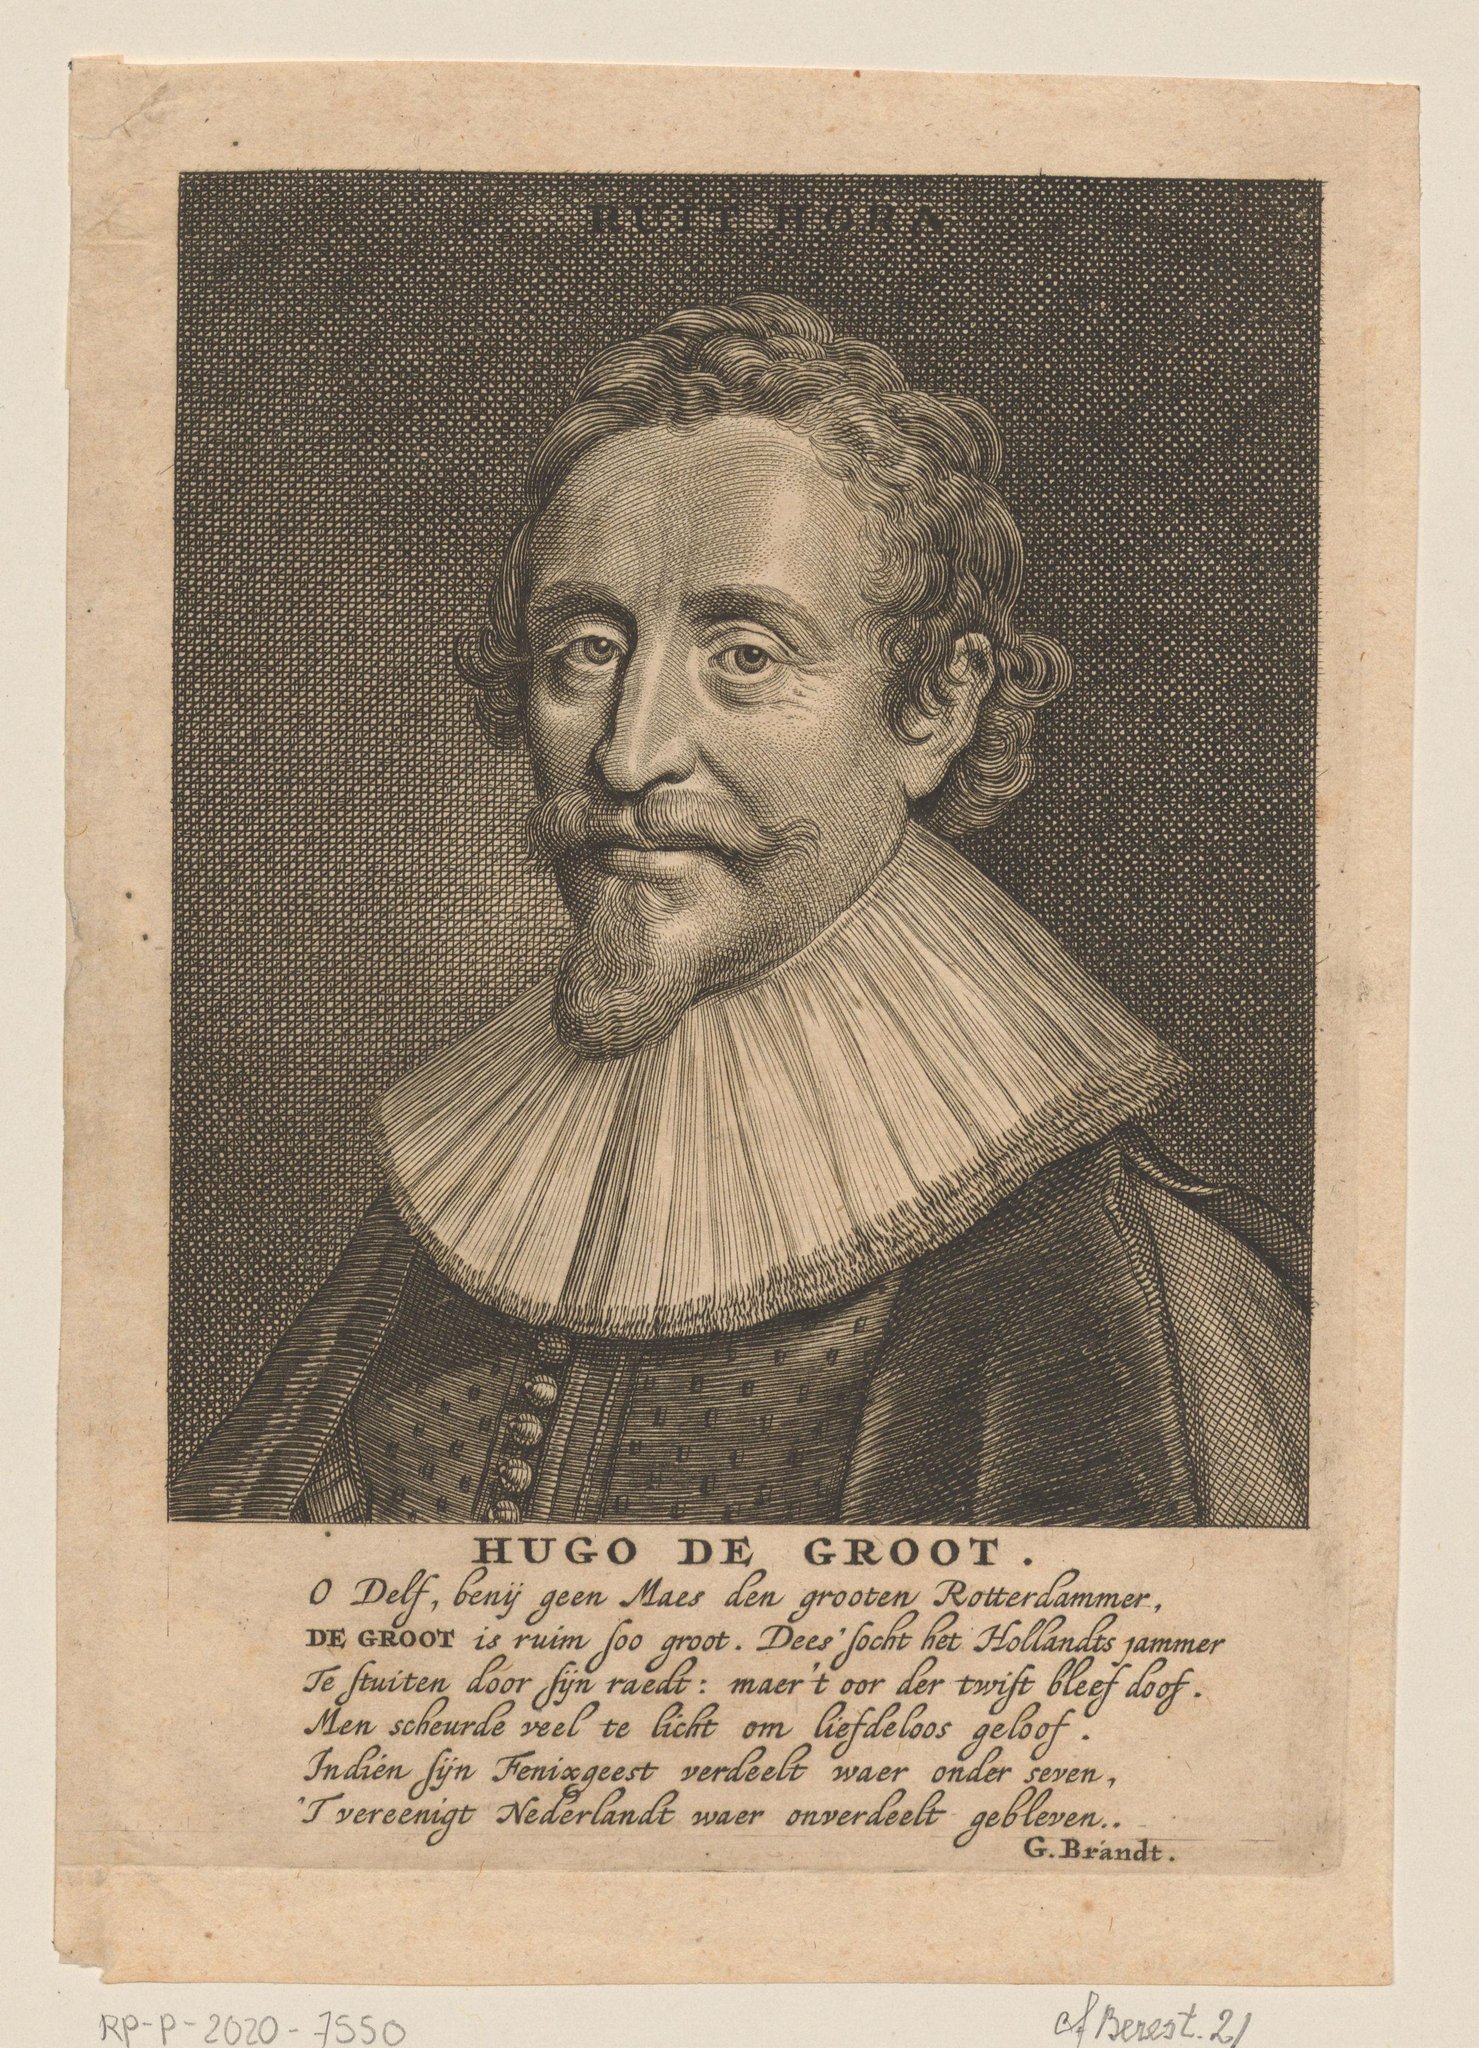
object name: print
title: Portret van Hugo de Groot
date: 1674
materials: paper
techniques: engraving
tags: delft, hugo de groot, historical persons, portrait of a writer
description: Prent uit: Geeraert (I), Brandt. Historie der Reformatie, en andre kerkelyke geschiedenissen, in en ontrent de Nederlanden. Amsterdam: Jan Rieuwertsz. (I) en Hendrik en Dirk Boom, 1674, dl. 2. Prent toegevoegd aan: Sententie uyt-ghesproocken ... over Rombout Hogerbeetz. Den Haag: Hillebrant Jacobsz. van Wouw, [1619].